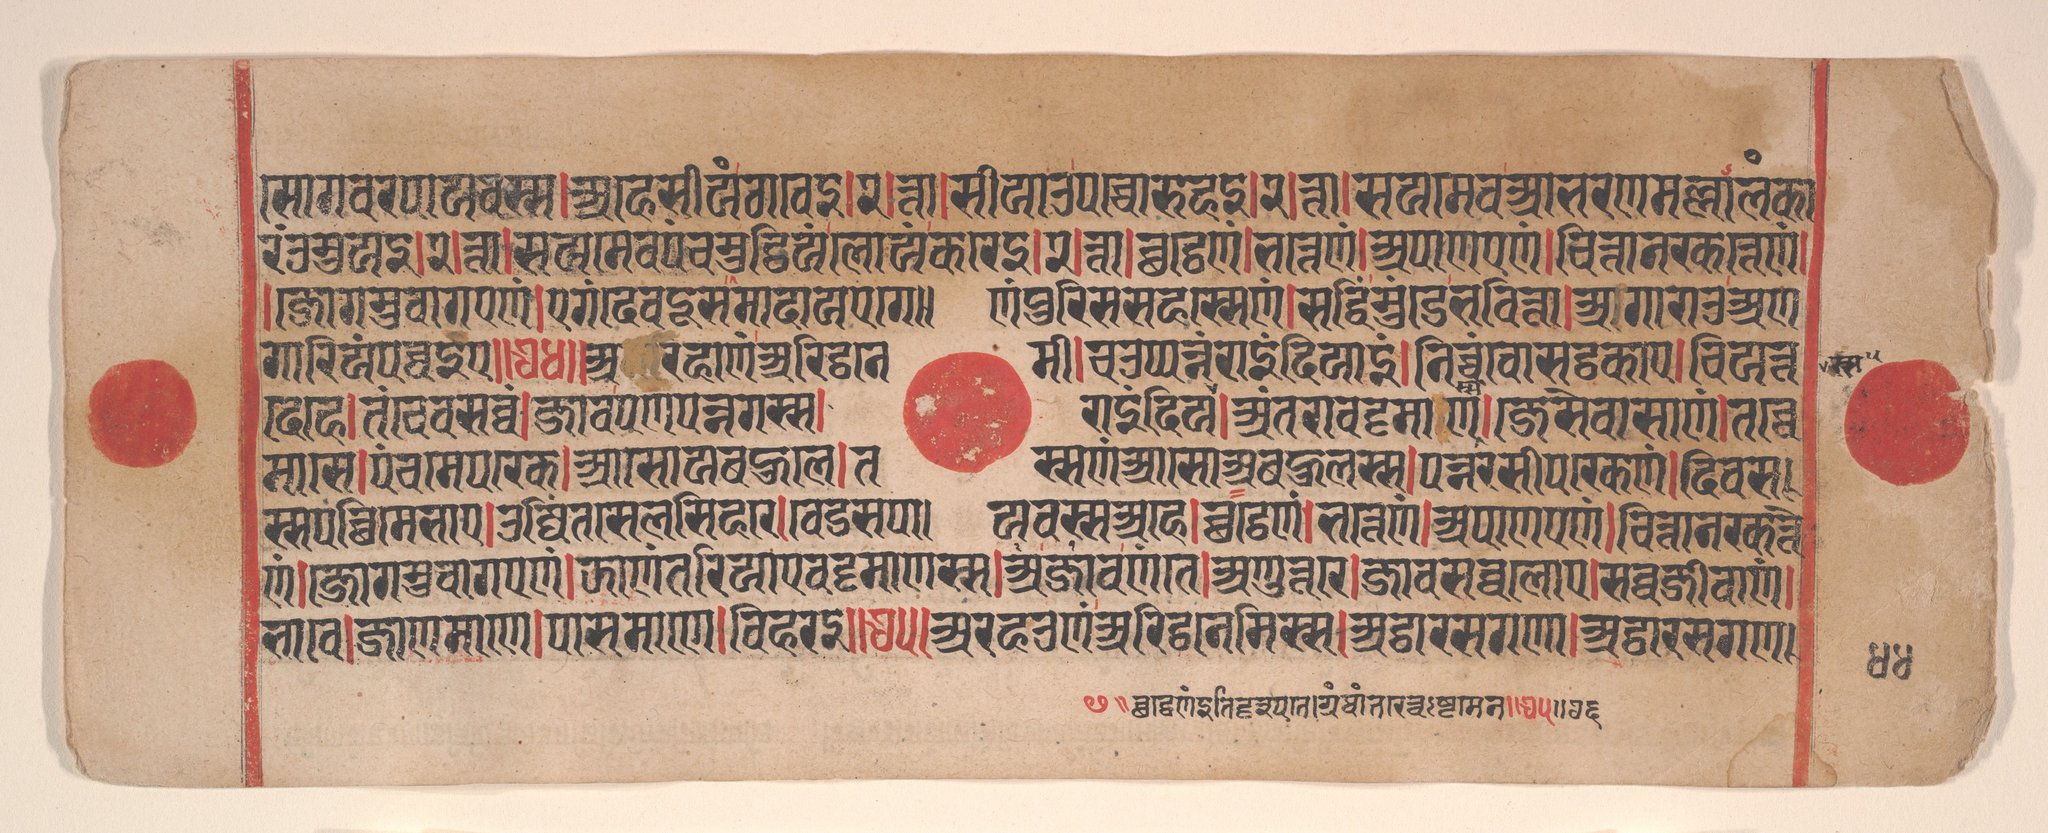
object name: folio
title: Leaf from a Kalpa Sutra (Jain Book of Rituals)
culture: indian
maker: bhadrabahu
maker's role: artist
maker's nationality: indian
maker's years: 356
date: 1401-1500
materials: gold, ink, paper, watercolor